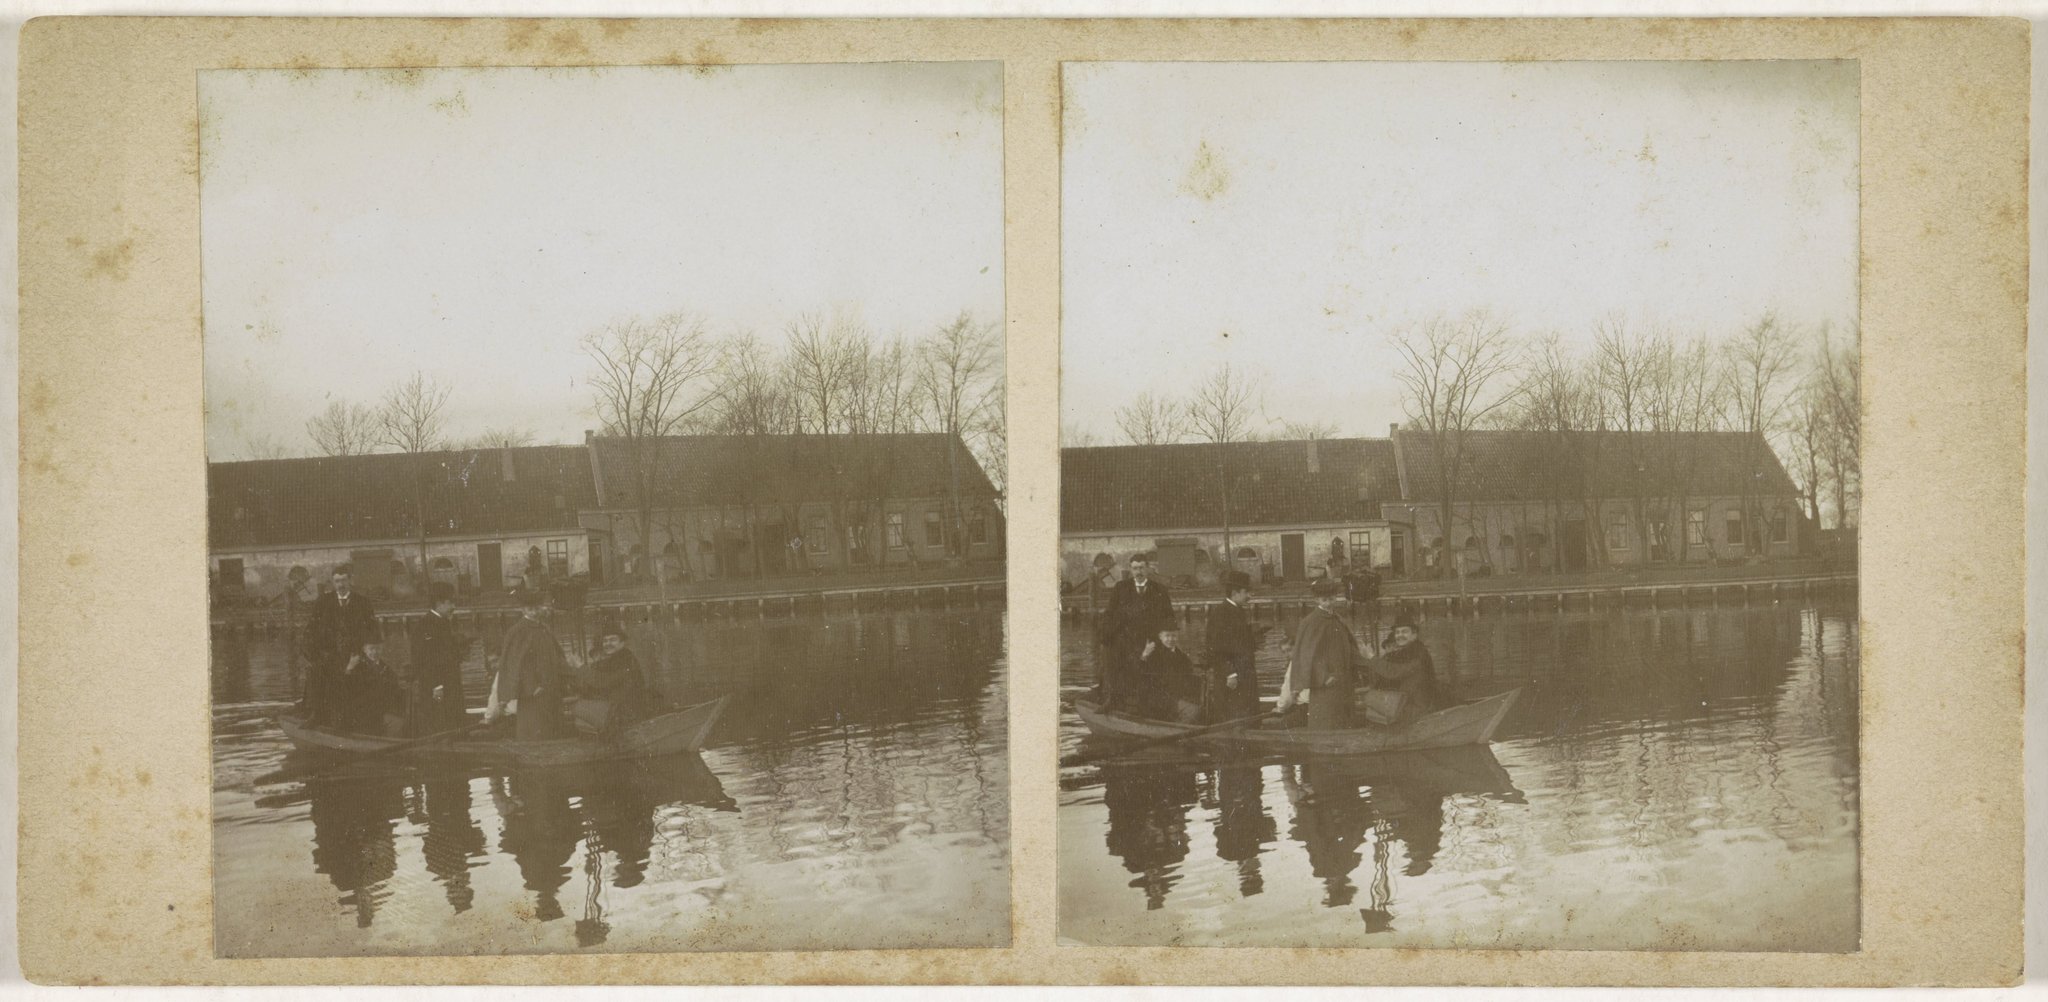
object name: stereograph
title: Uitje van de Amsterdamsche Amateurfotografenvereniging (AFV) op de Vecht, met camera's in boot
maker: h. ameschot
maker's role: verzamelaar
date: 1890-1895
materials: cardboard, paper, photographic support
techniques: gelatin silver print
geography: breukelen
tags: breukelen